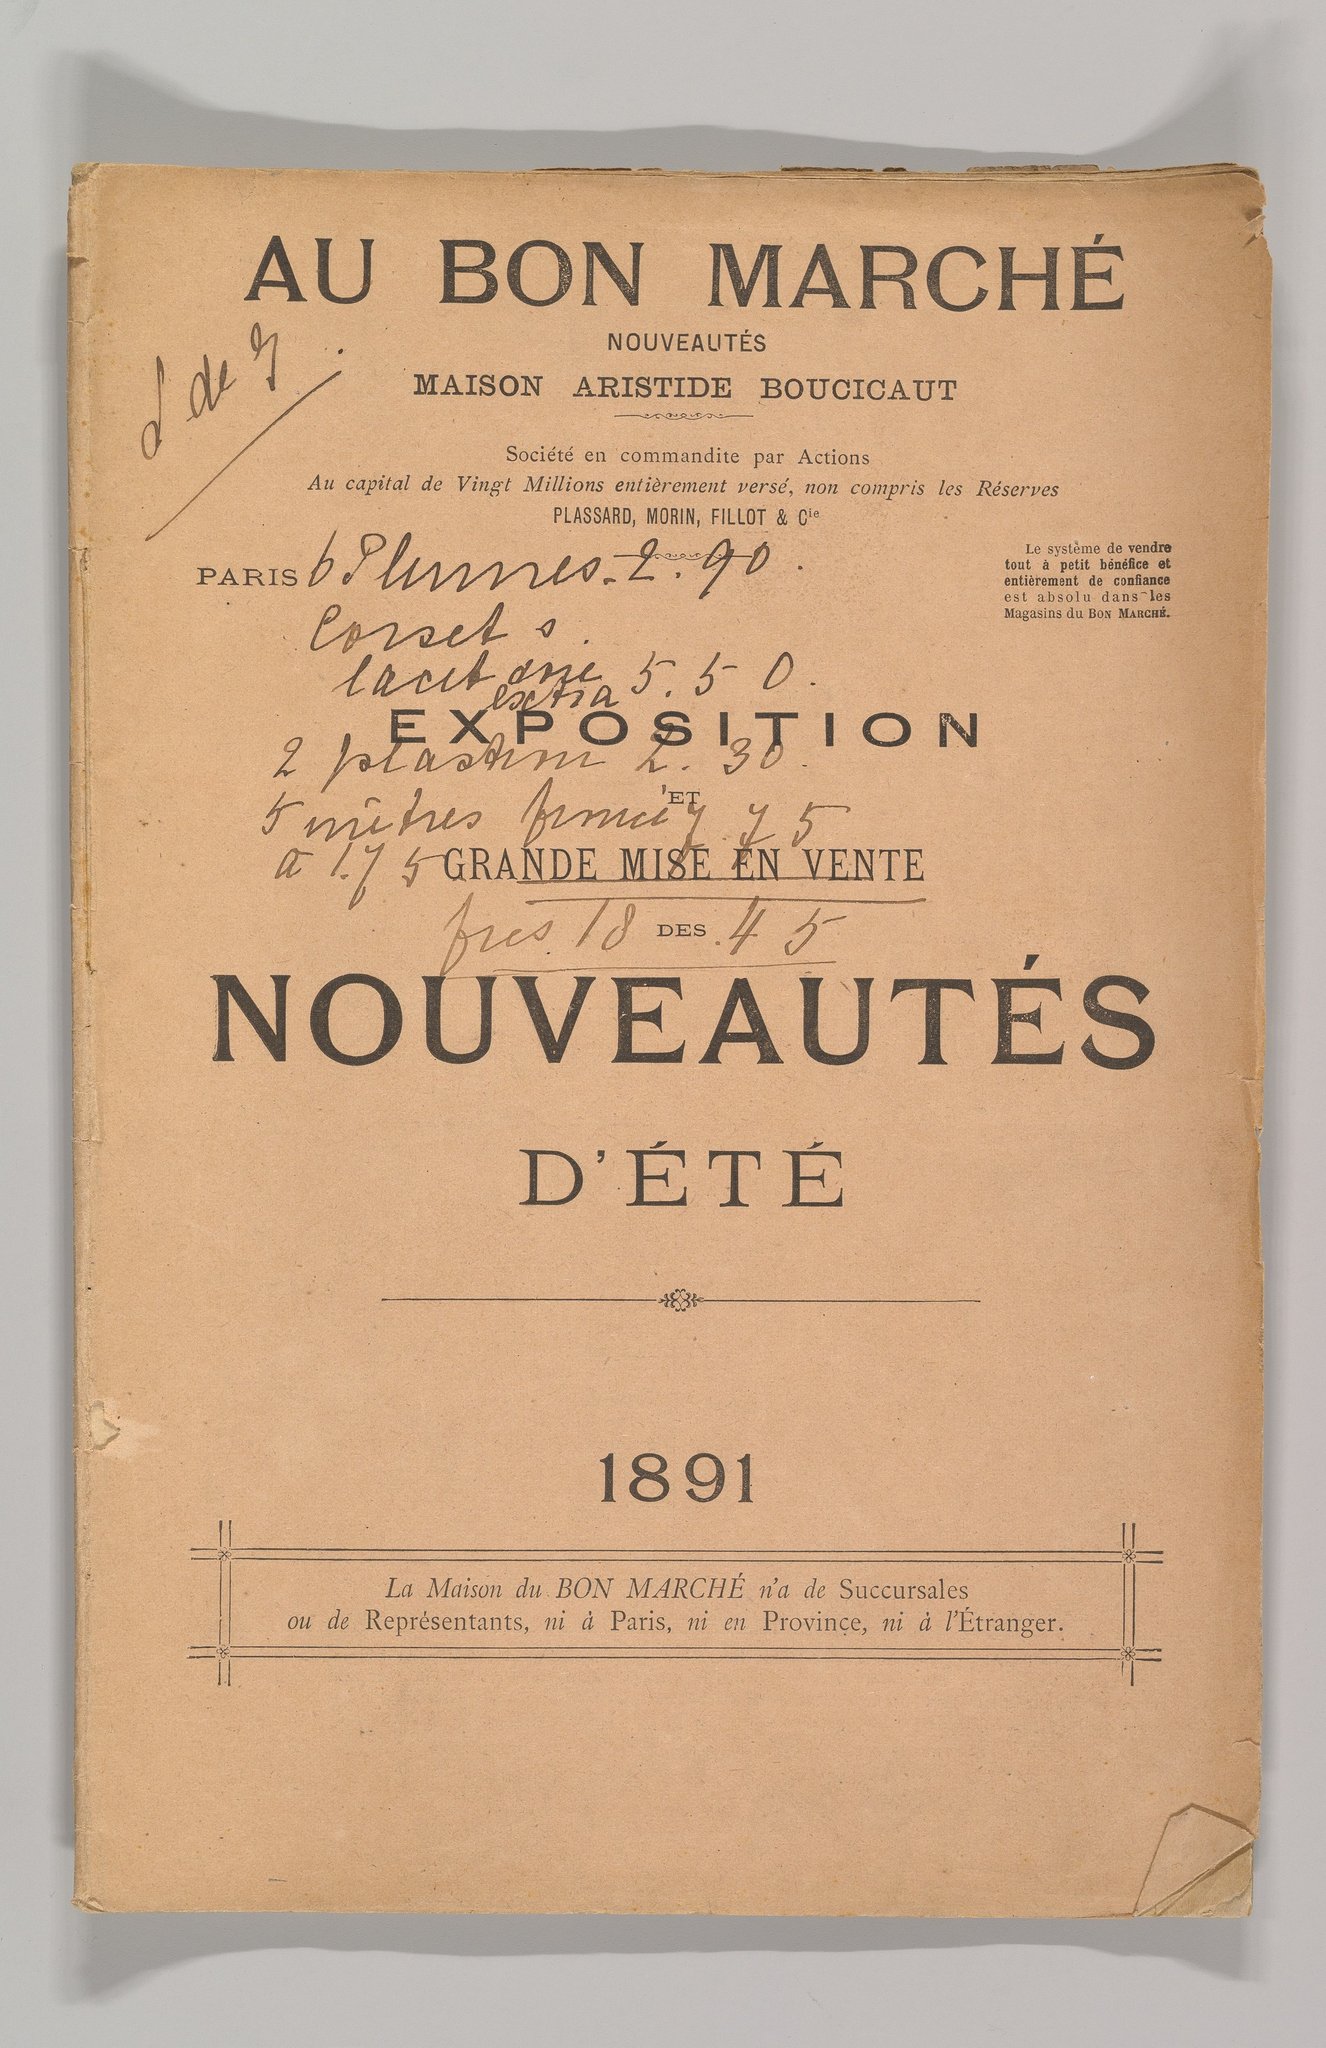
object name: book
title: Au Bon Marché-Exposition et Grande Misé en Vente des Nouveautés d'Été 1891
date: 1891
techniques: engraving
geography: france